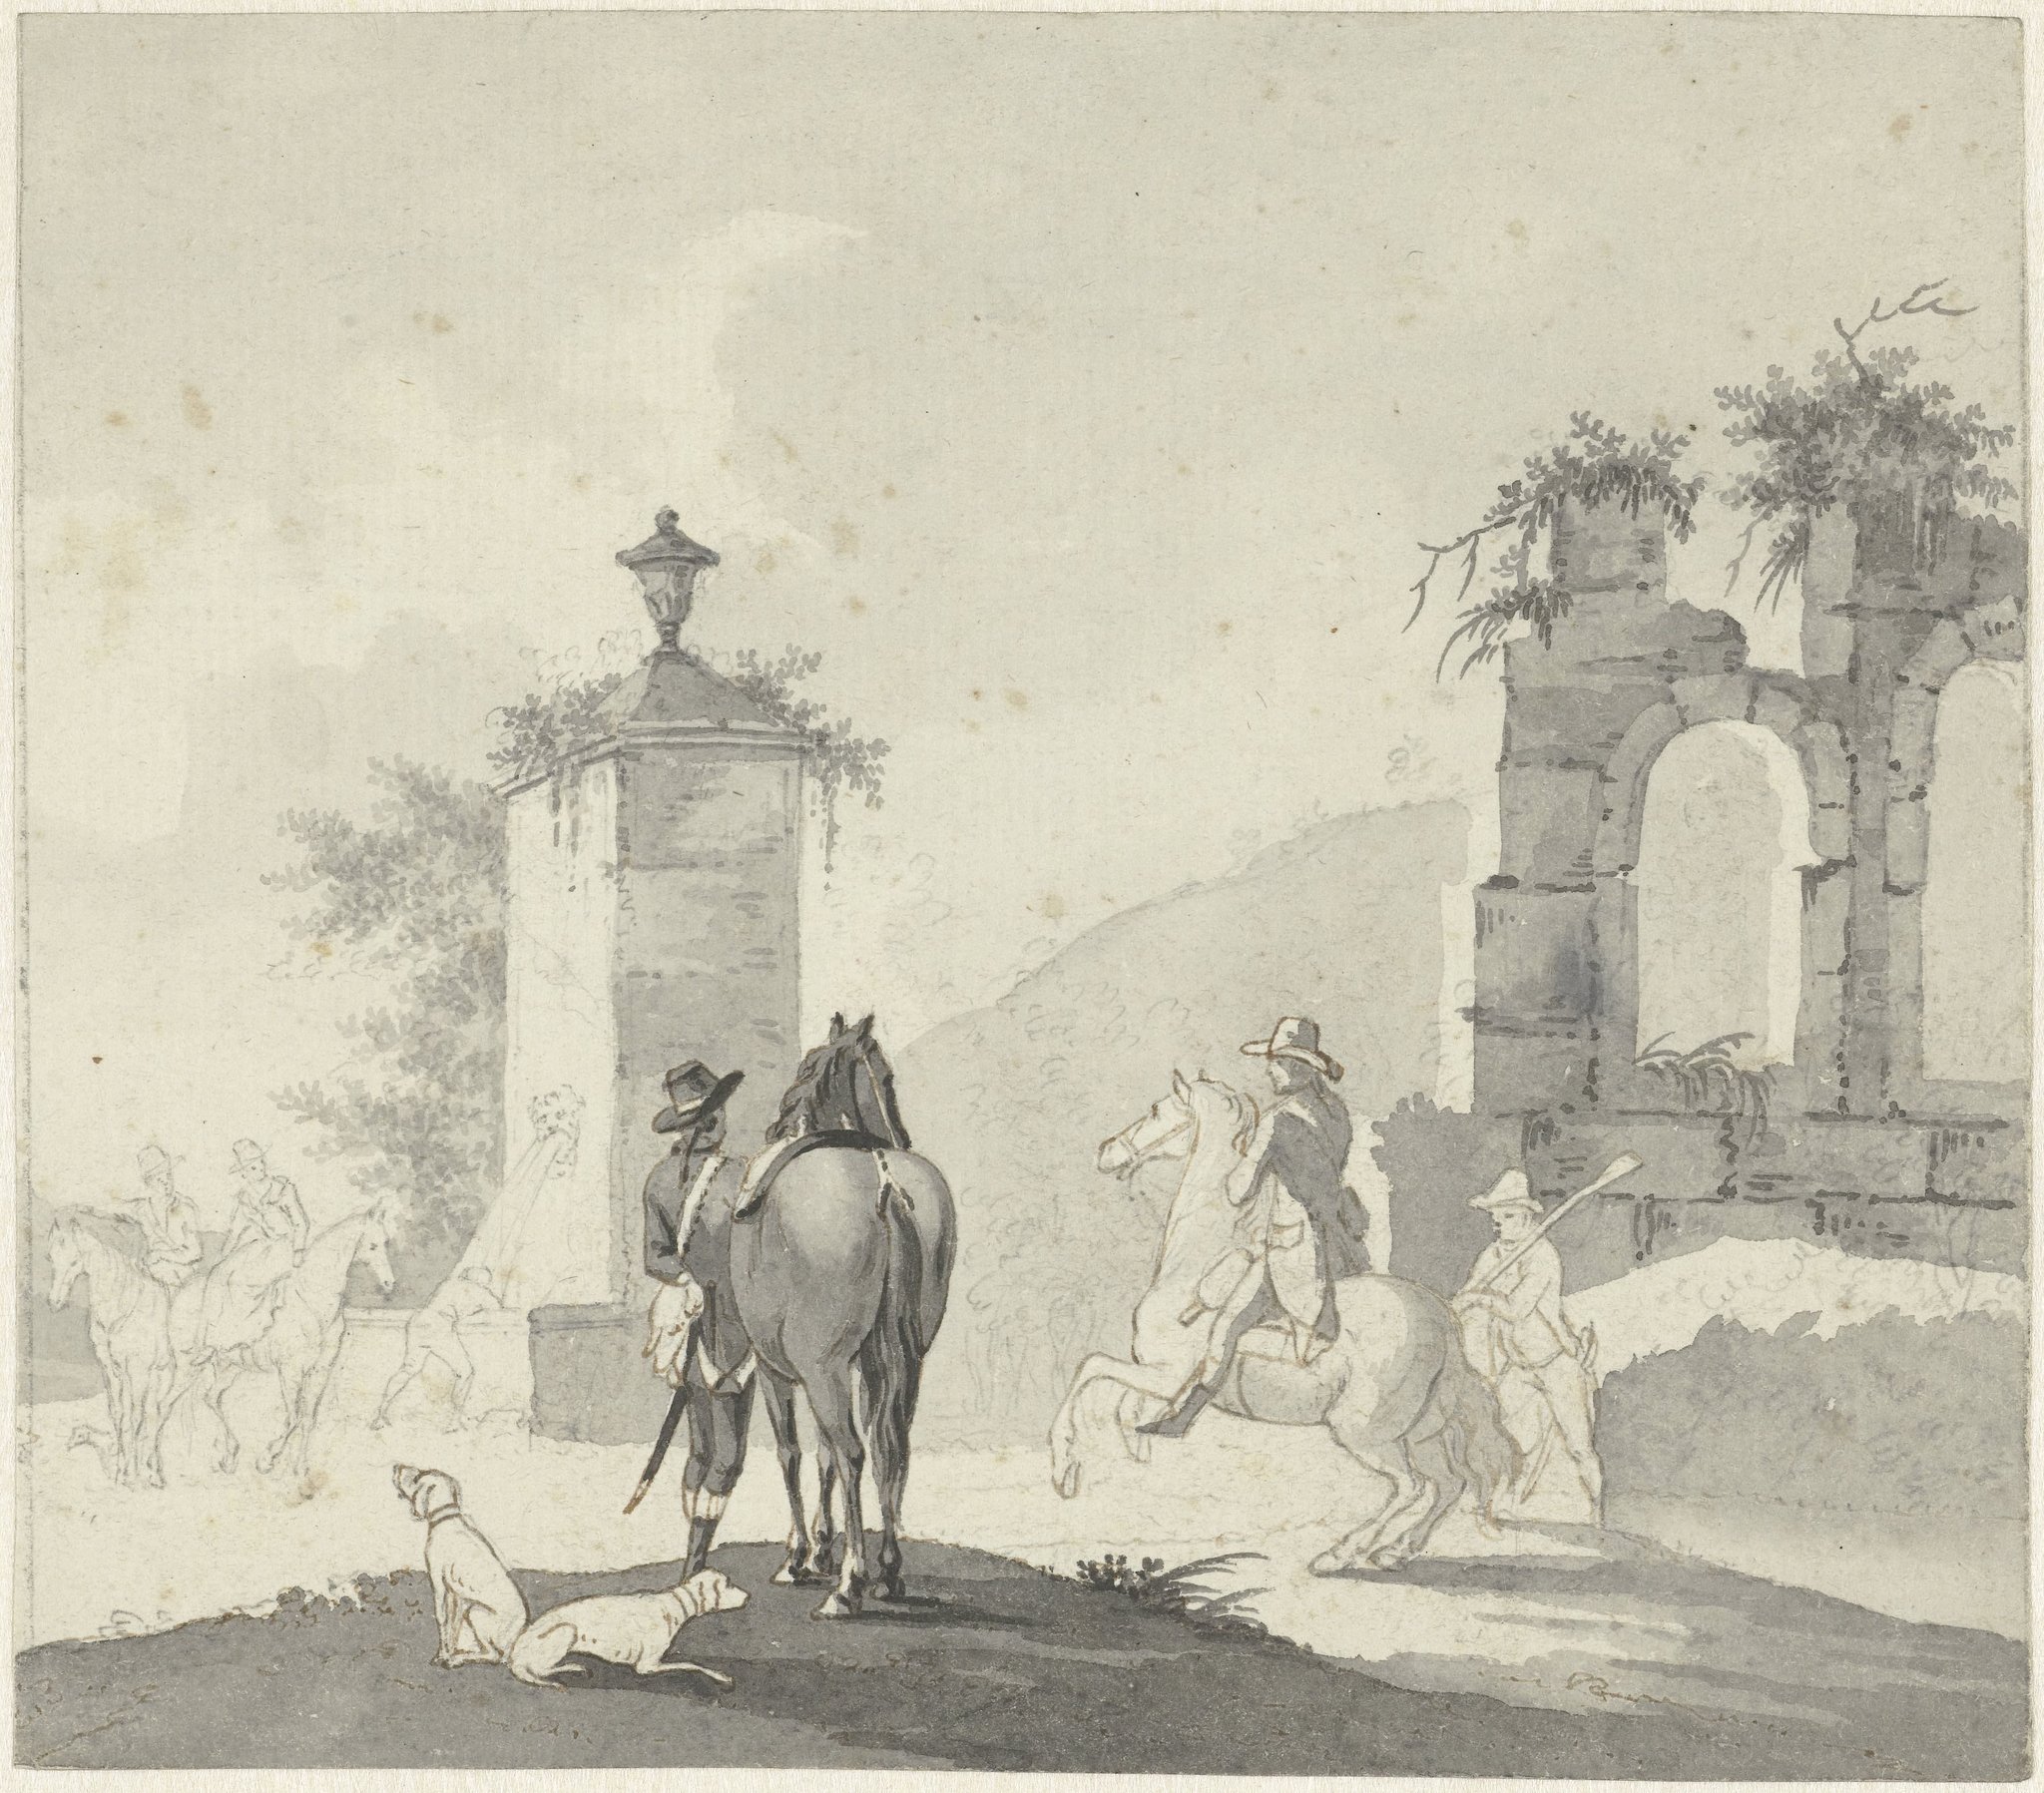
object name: drawing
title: Ruiters bij een drinkplaats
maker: Anonymous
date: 1700-1800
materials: ink, paper, pencil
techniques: brush, pen